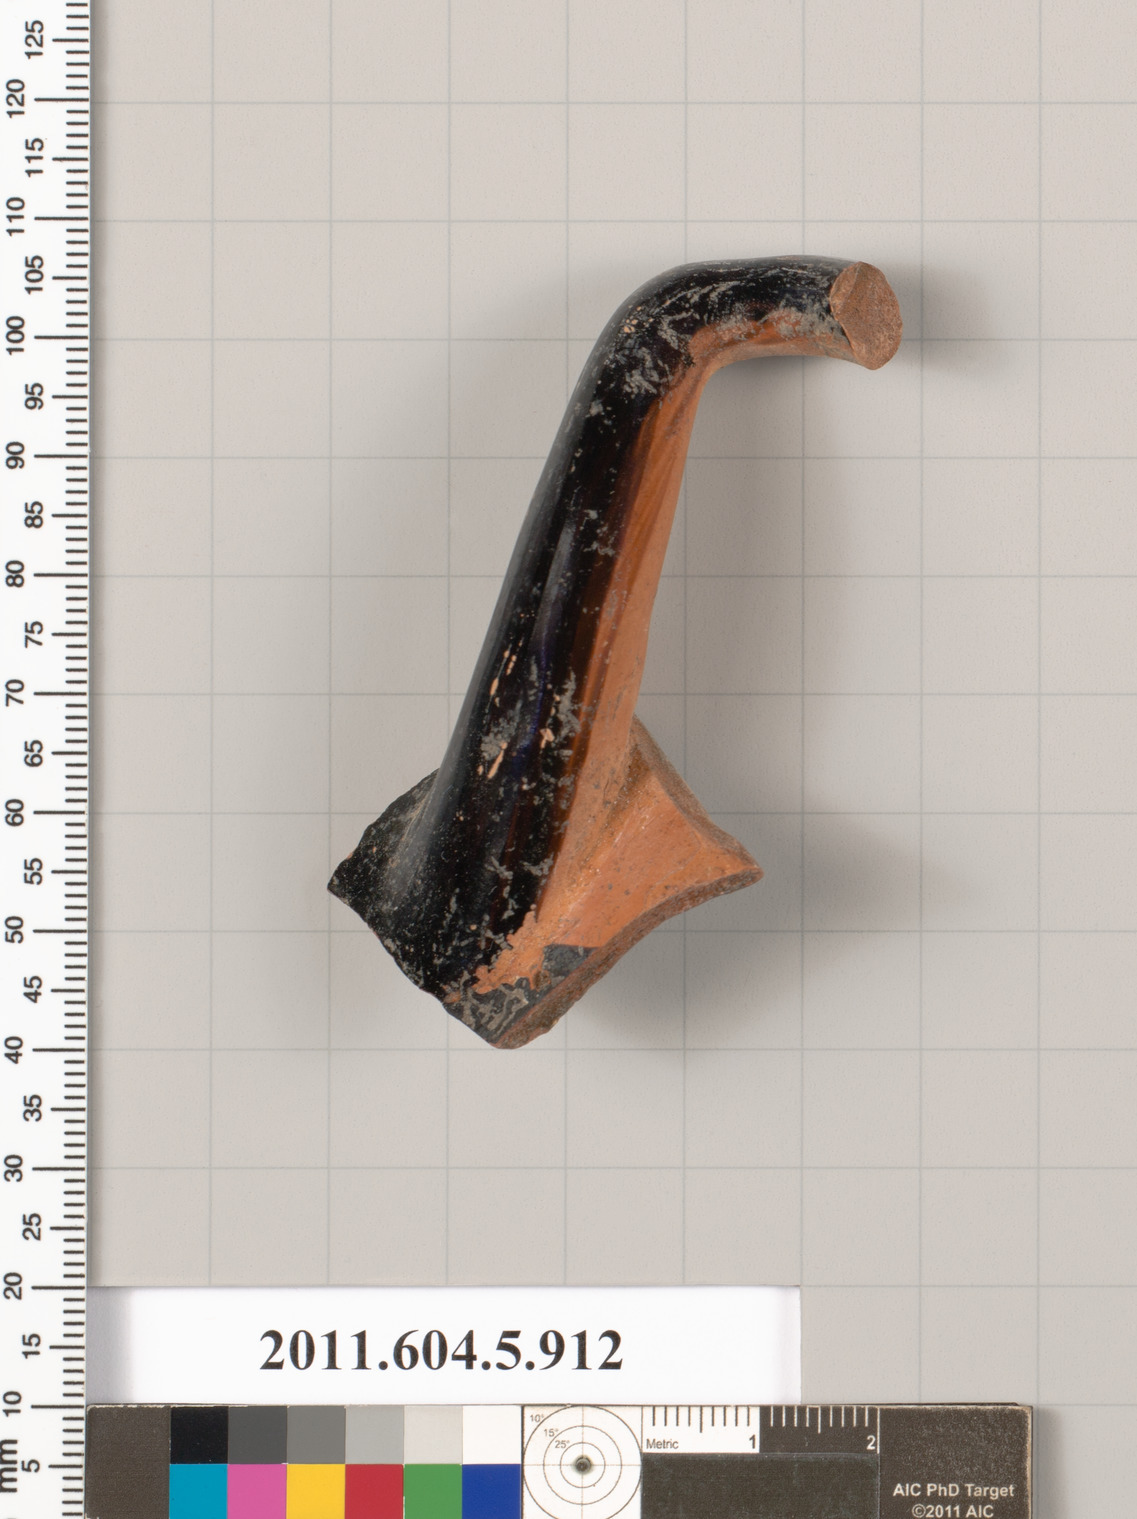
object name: kylix fragment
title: Terracotta fragment of a kylix (drinking cup)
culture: greek, attic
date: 600-401 BCE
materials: terracotta